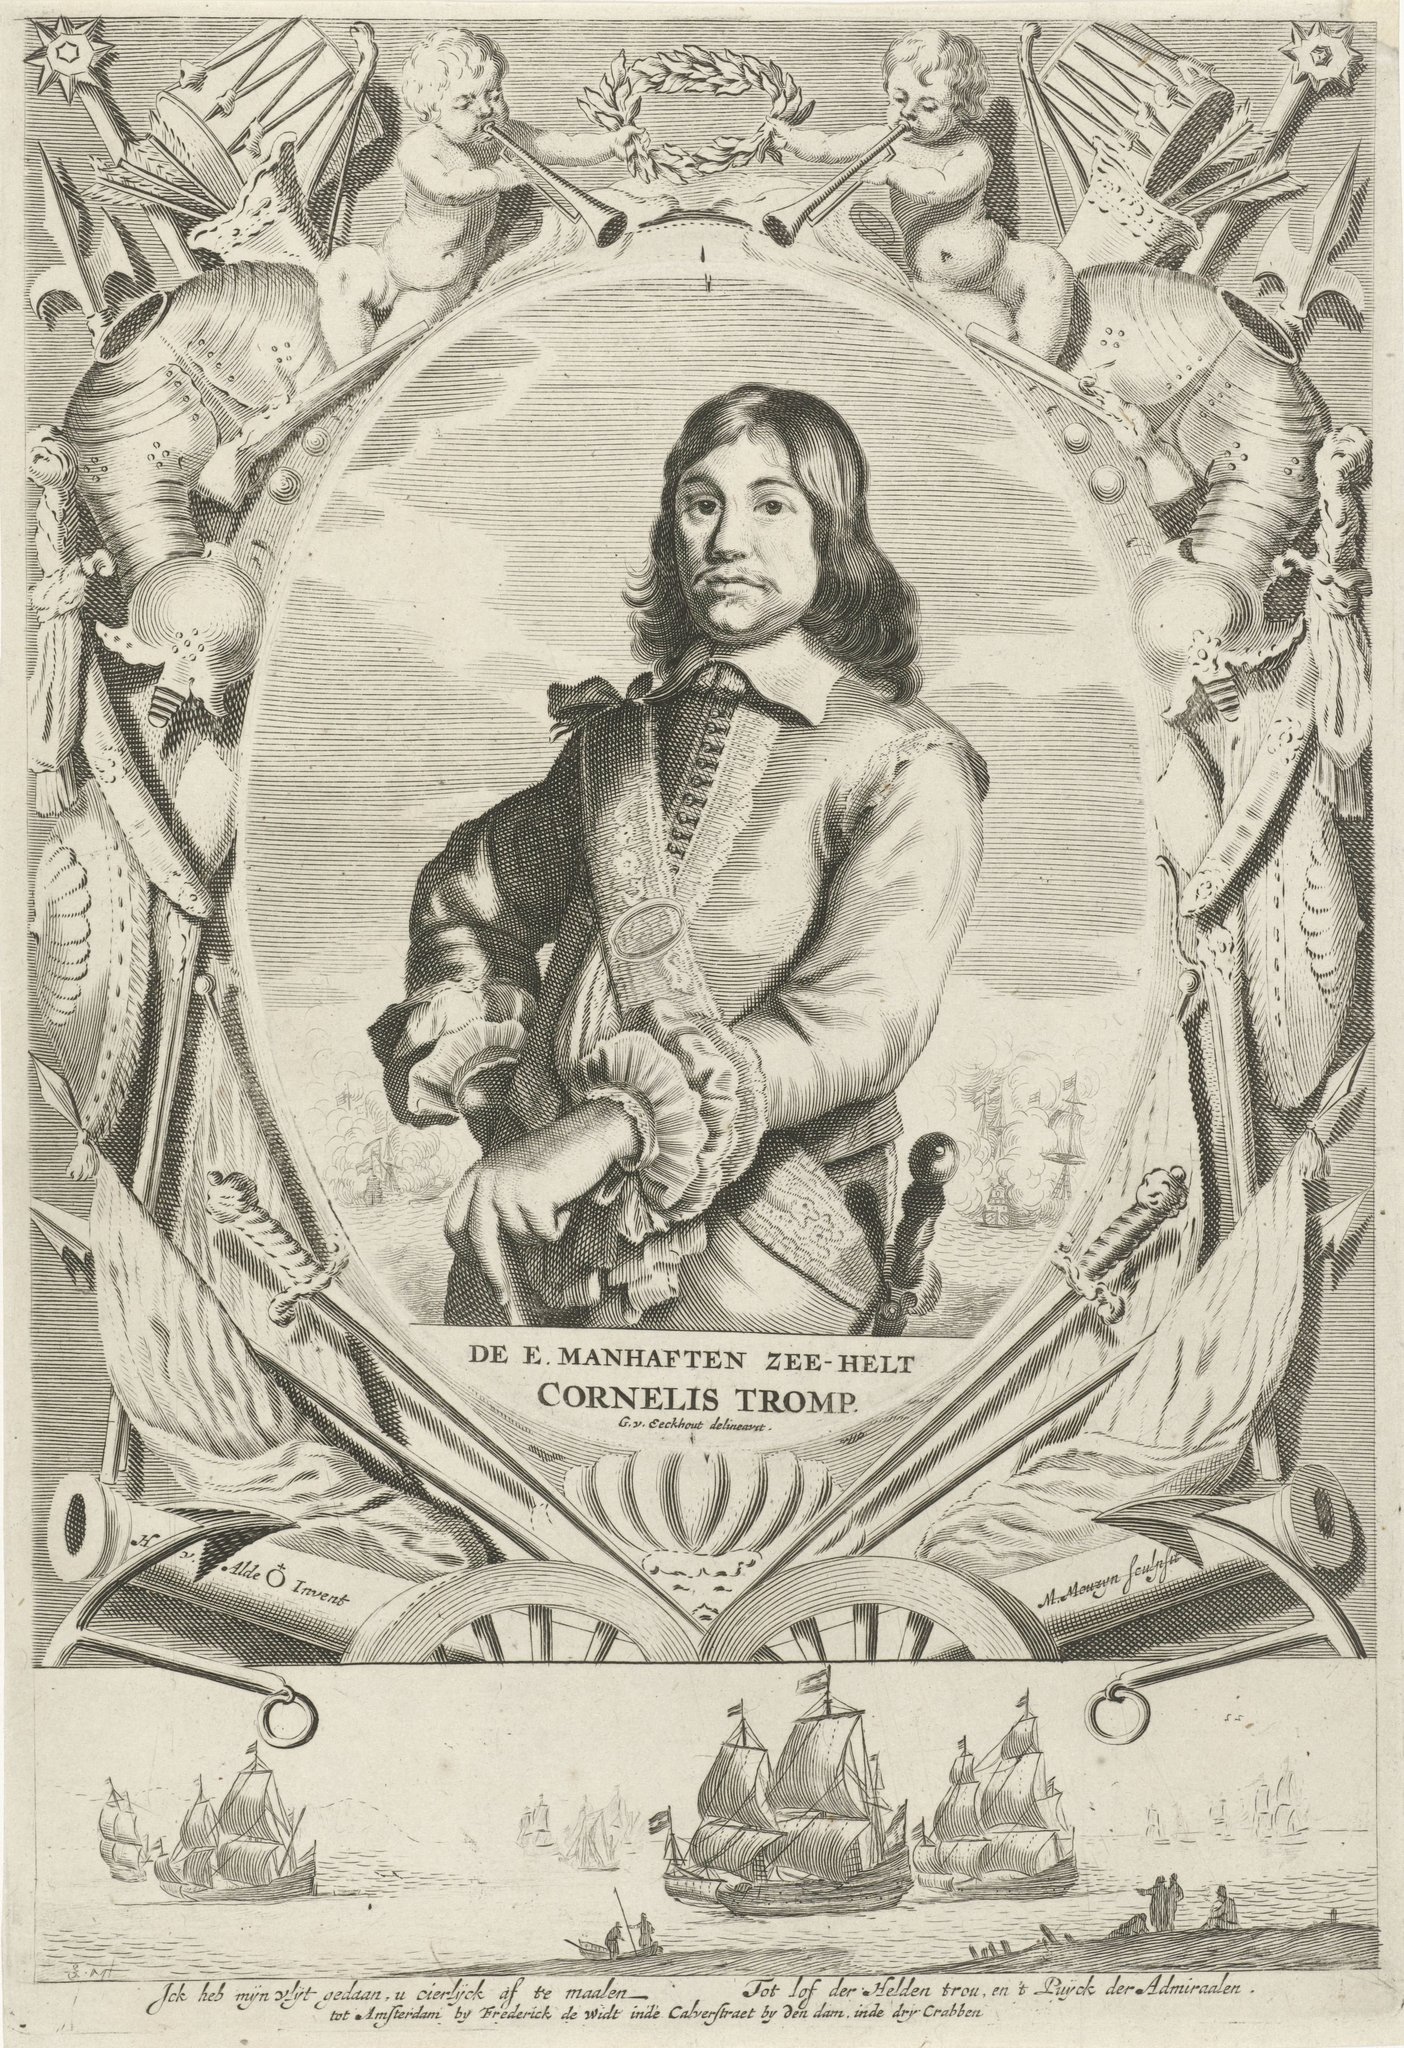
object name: print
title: Portret van Cornelis Tromp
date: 1640-1706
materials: paper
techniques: engraving, etching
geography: amsterdam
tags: rotterdam, amsterdam, cornelis tromp, battle, fighting in general (+ naval force), navy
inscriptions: collector's mark: Lugt 2228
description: Portret van vlootvoogd Cornelis Tromp. Op de achtergrond een zeeslag. Het portret is gevat in ornamentele lijst met vlaggen, zwaarden, kanonnen, harnasdelen en wordt bekroond door twee putti, die een lauwerkrans ophouden. Onderaan in de marge een zeegezicht met zeilschepen.